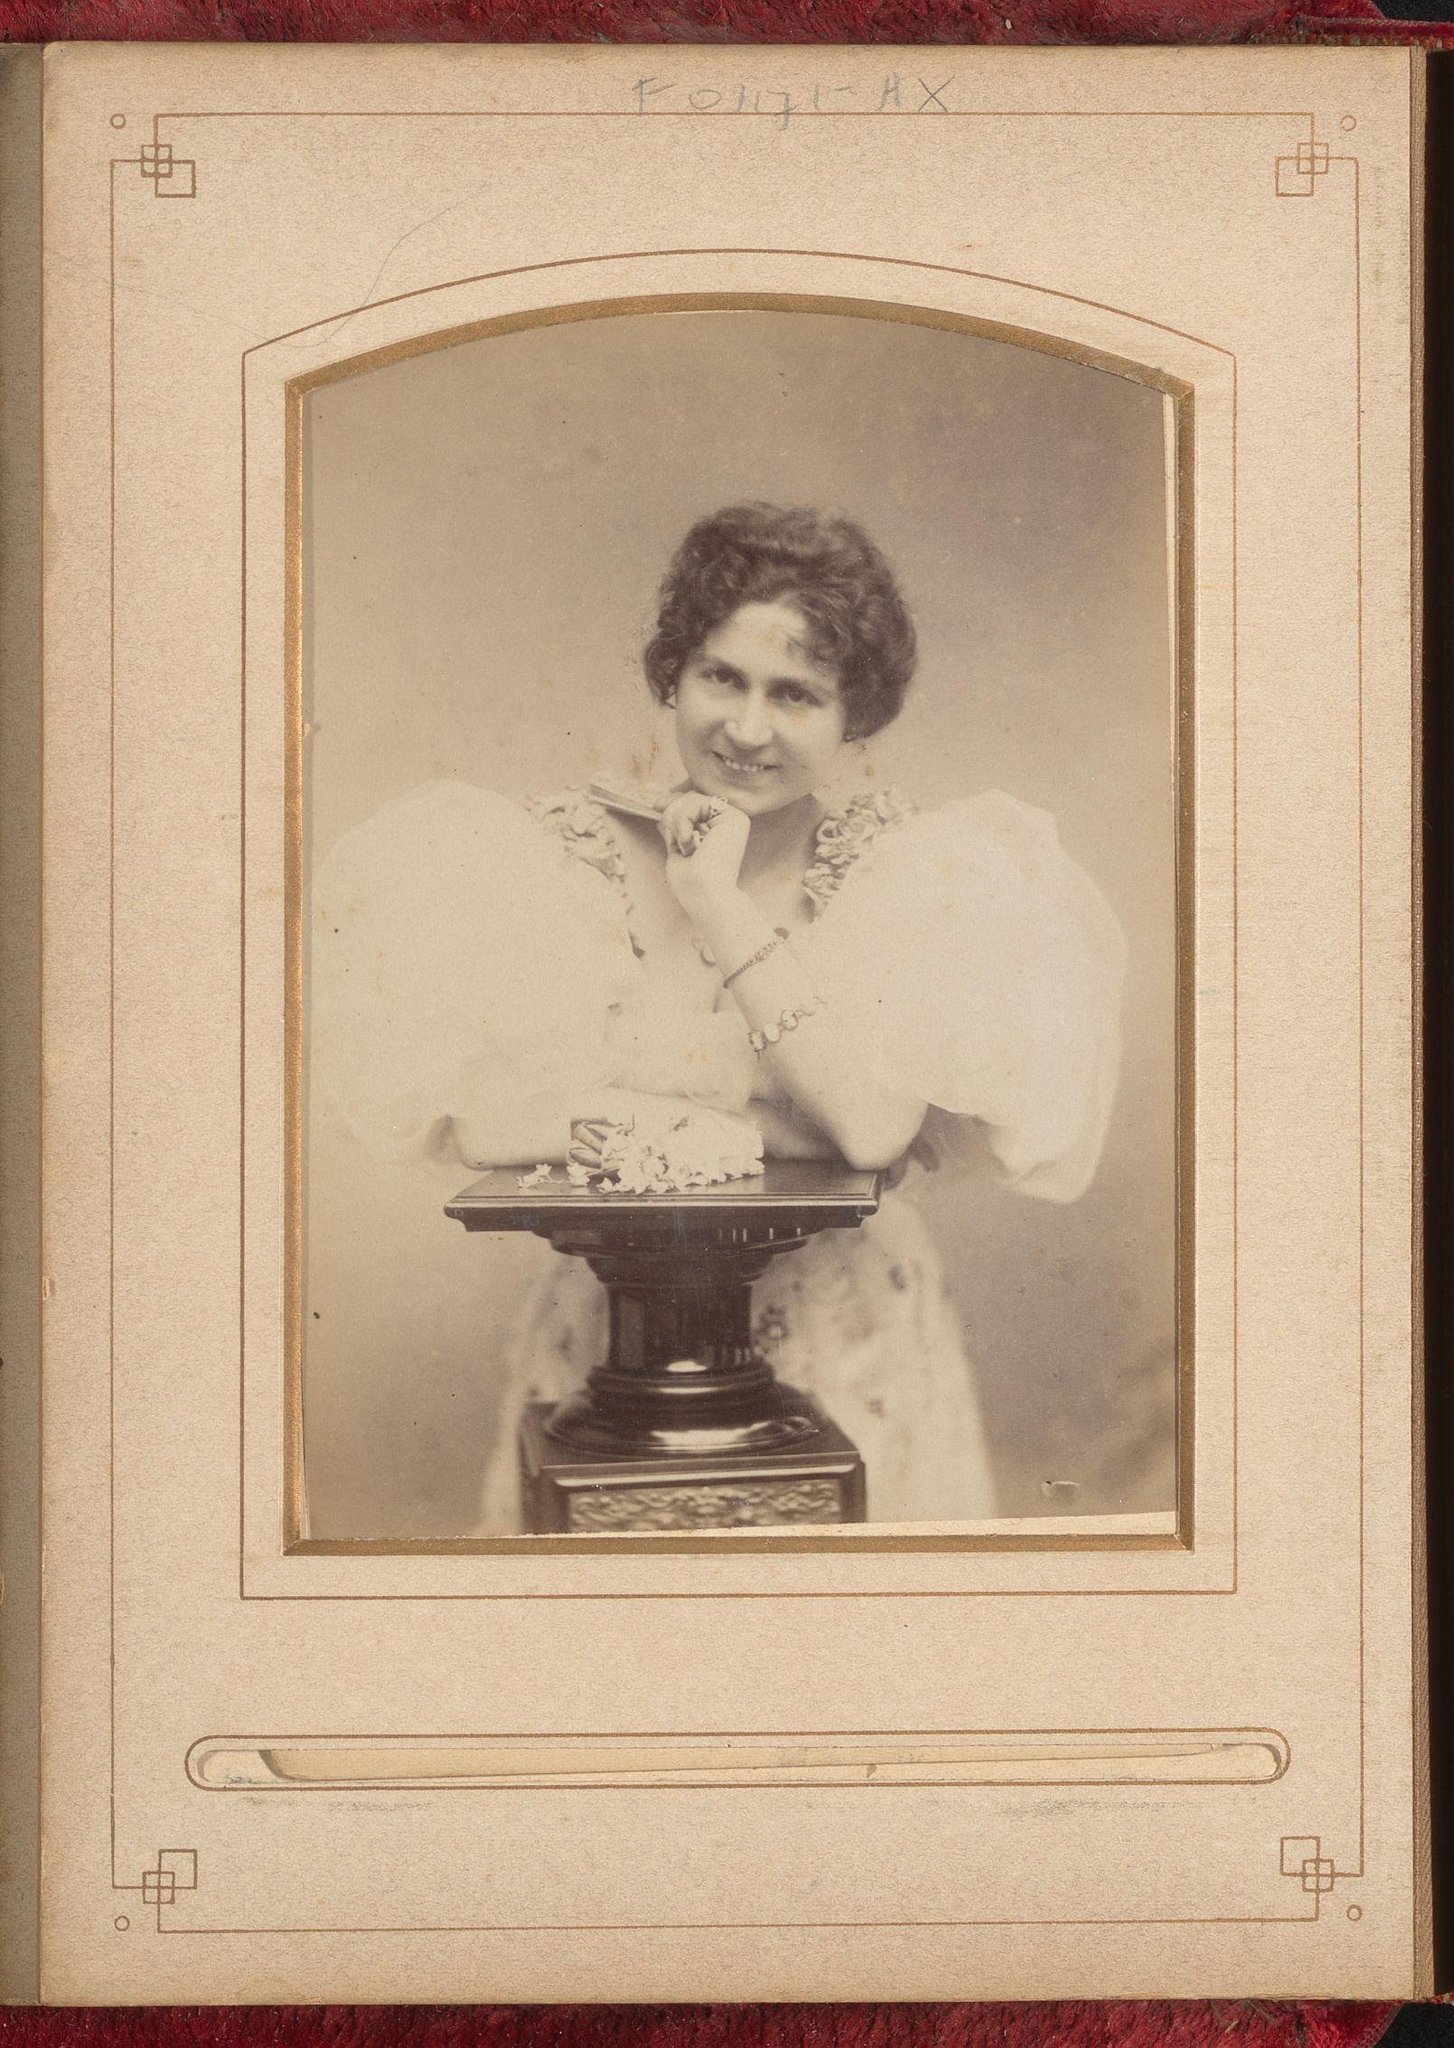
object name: cabinet photograph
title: Portret van een vrouw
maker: Anonymous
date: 1890-1900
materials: cardboard, photographic support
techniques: albumen print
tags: adult woman